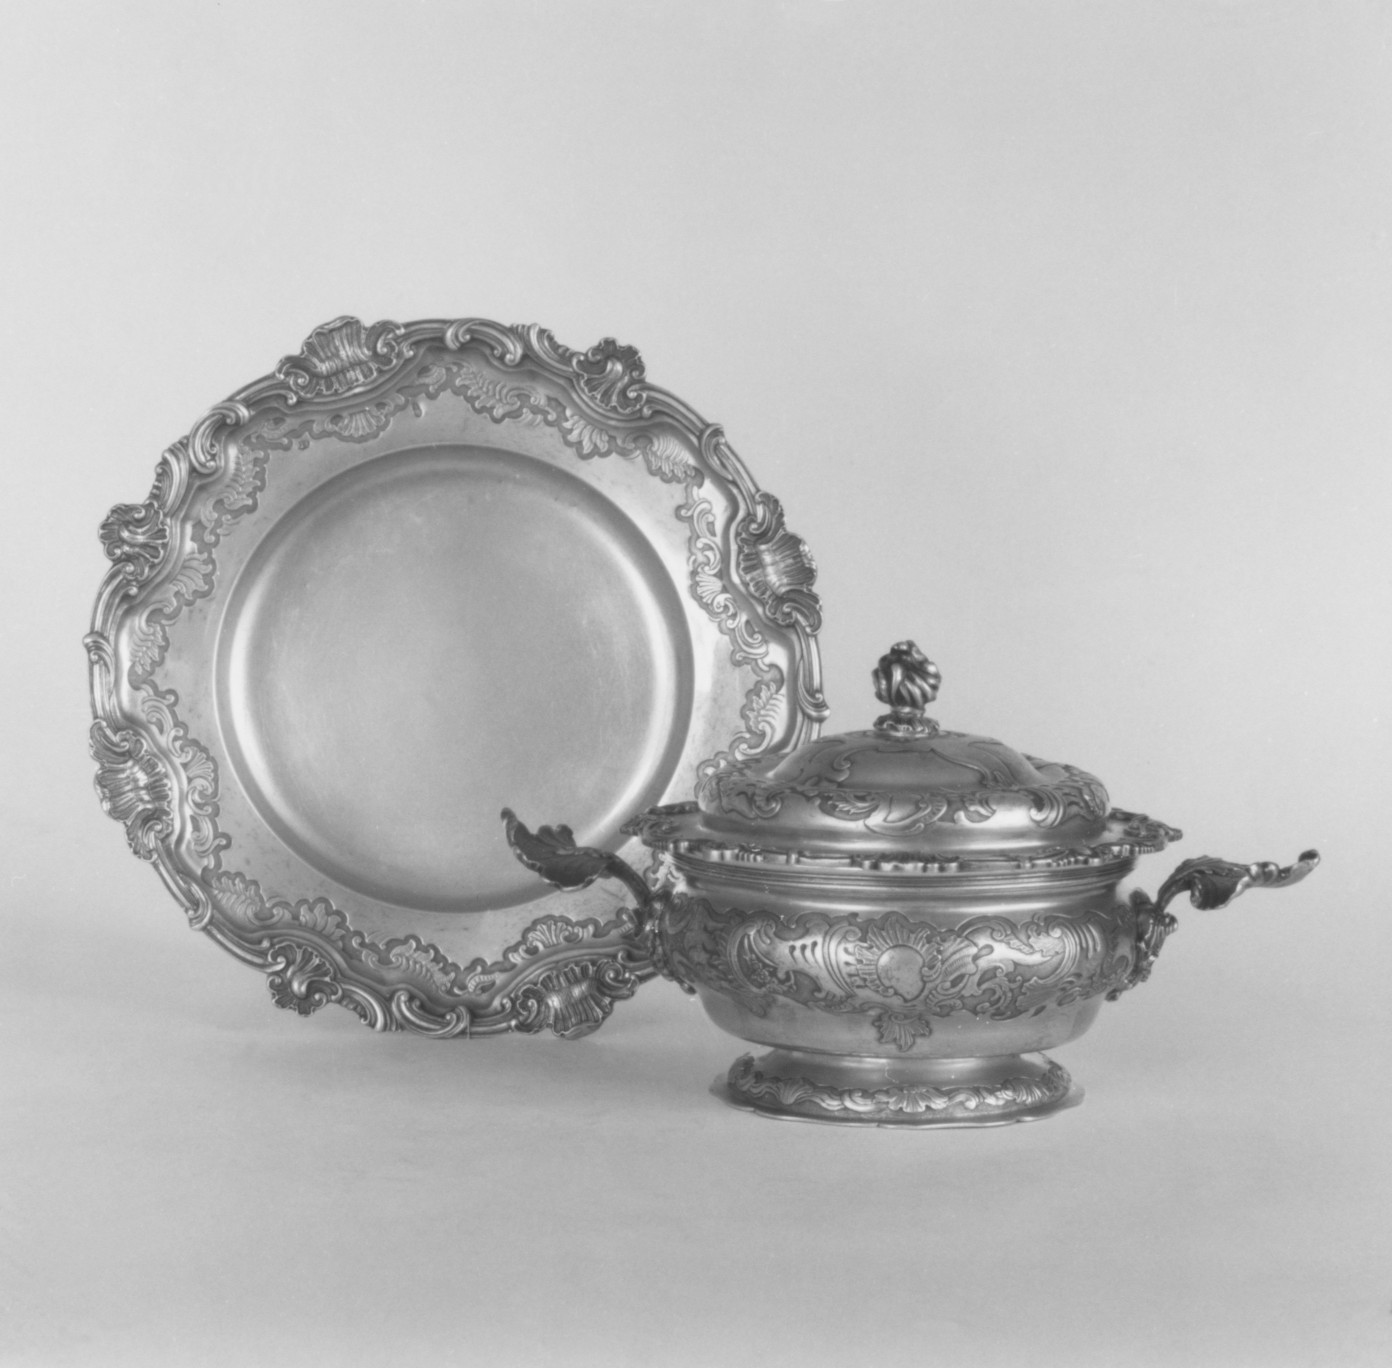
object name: stand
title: Stand for covered bowl (écuelle)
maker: emanuel drentwett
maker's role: maker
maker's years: 1681-1753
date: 1743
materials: silver gilt